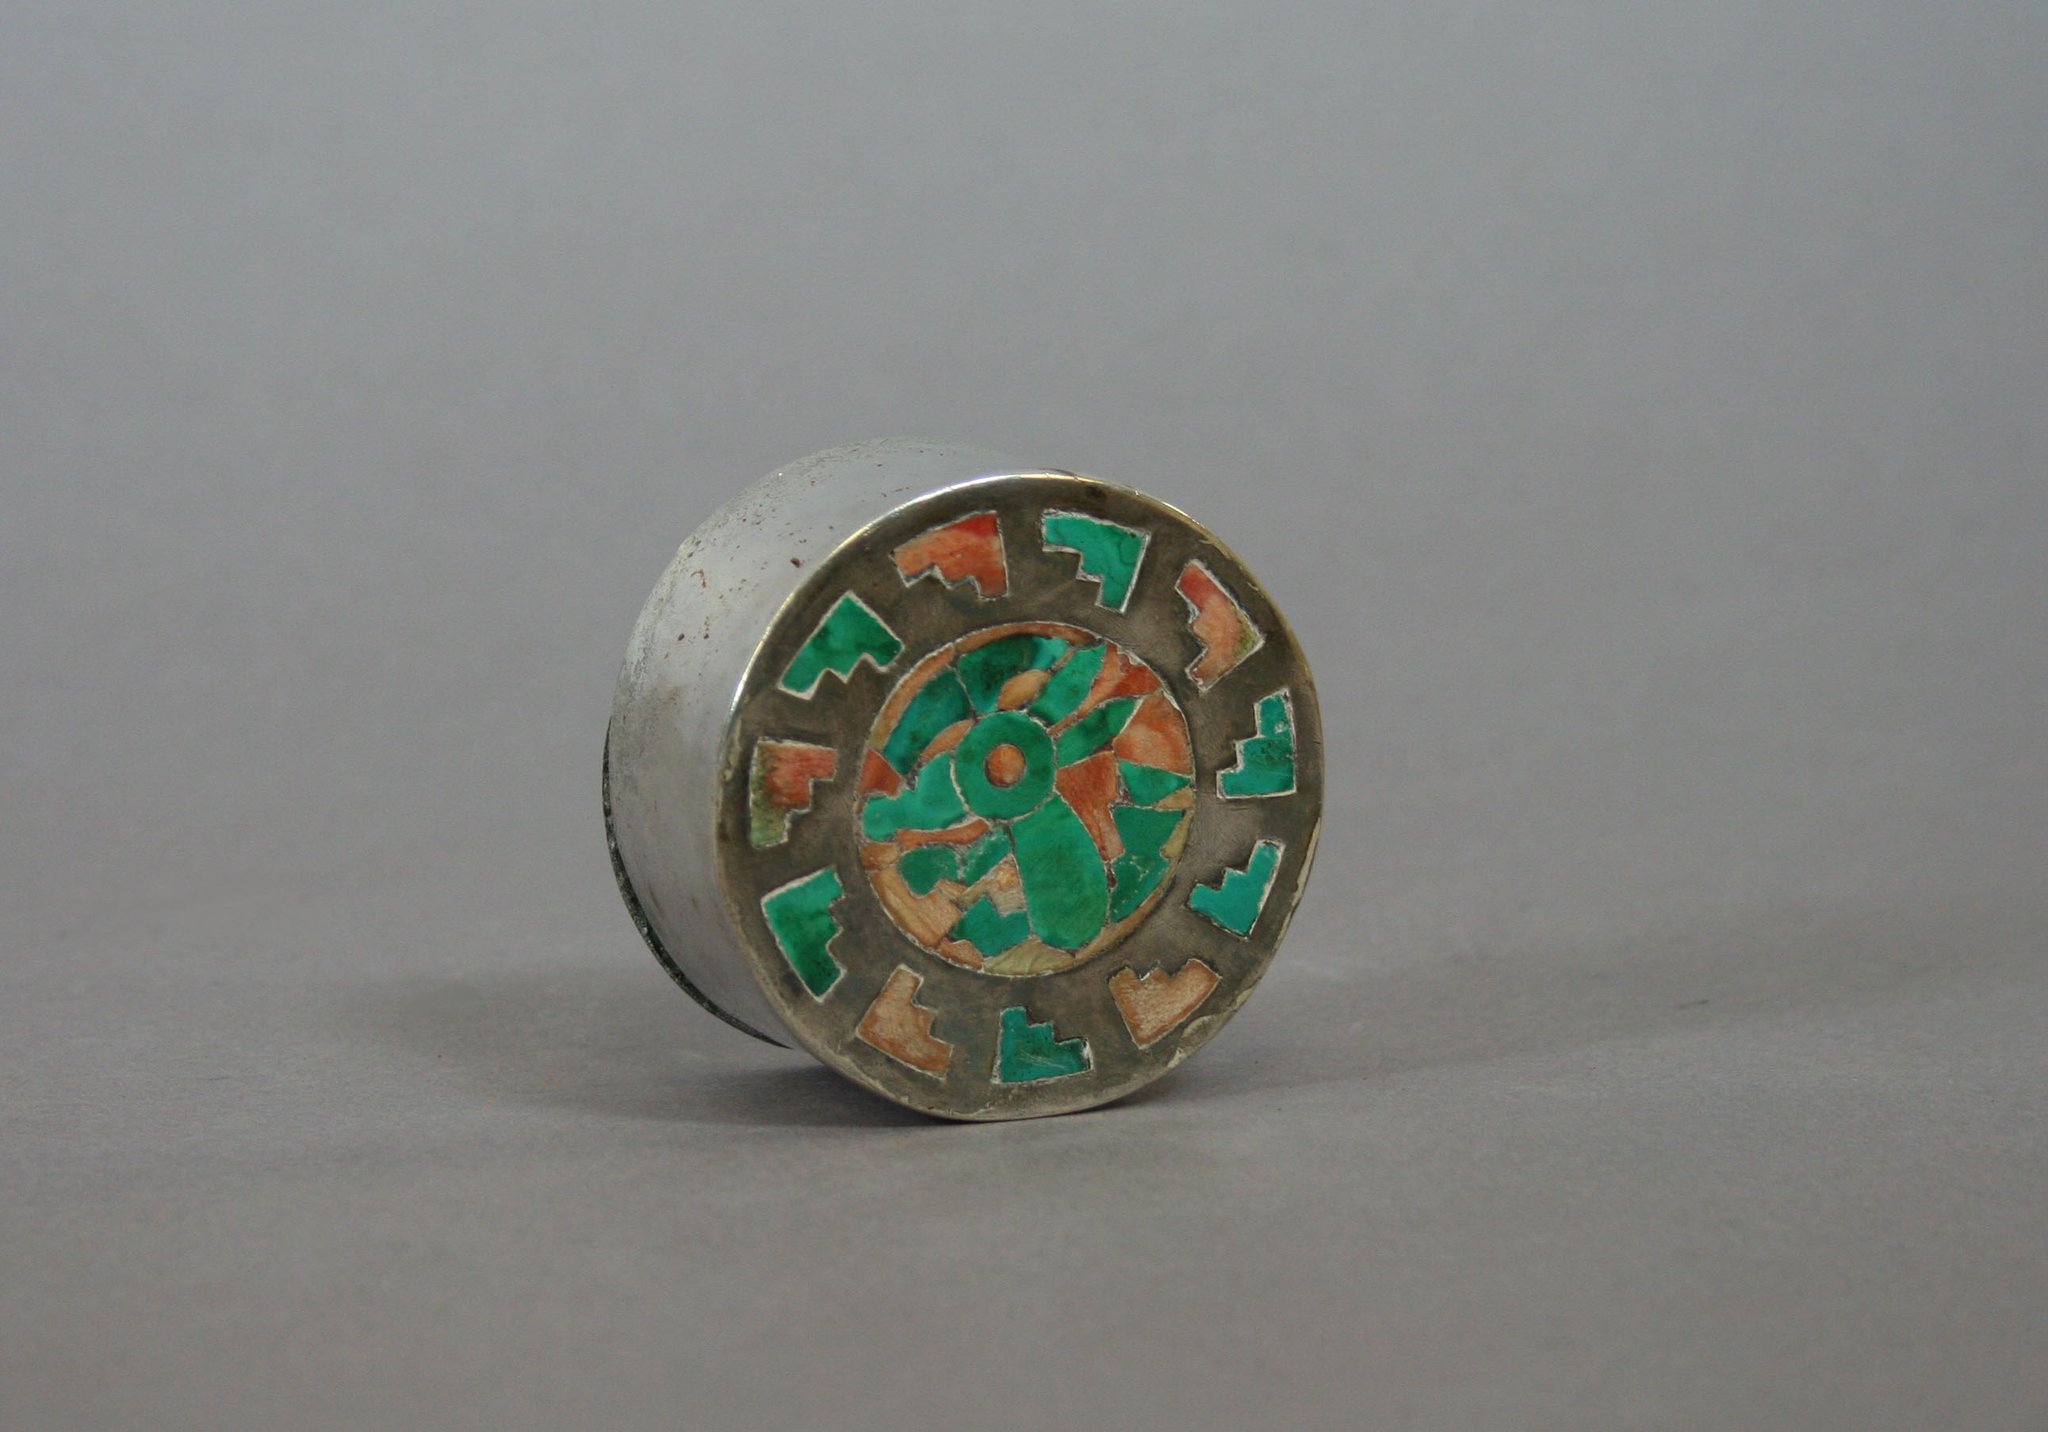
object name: earflares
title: Pair of earflares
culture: chincha or ica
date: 1201-1500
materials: shell, silver, stone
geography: peru